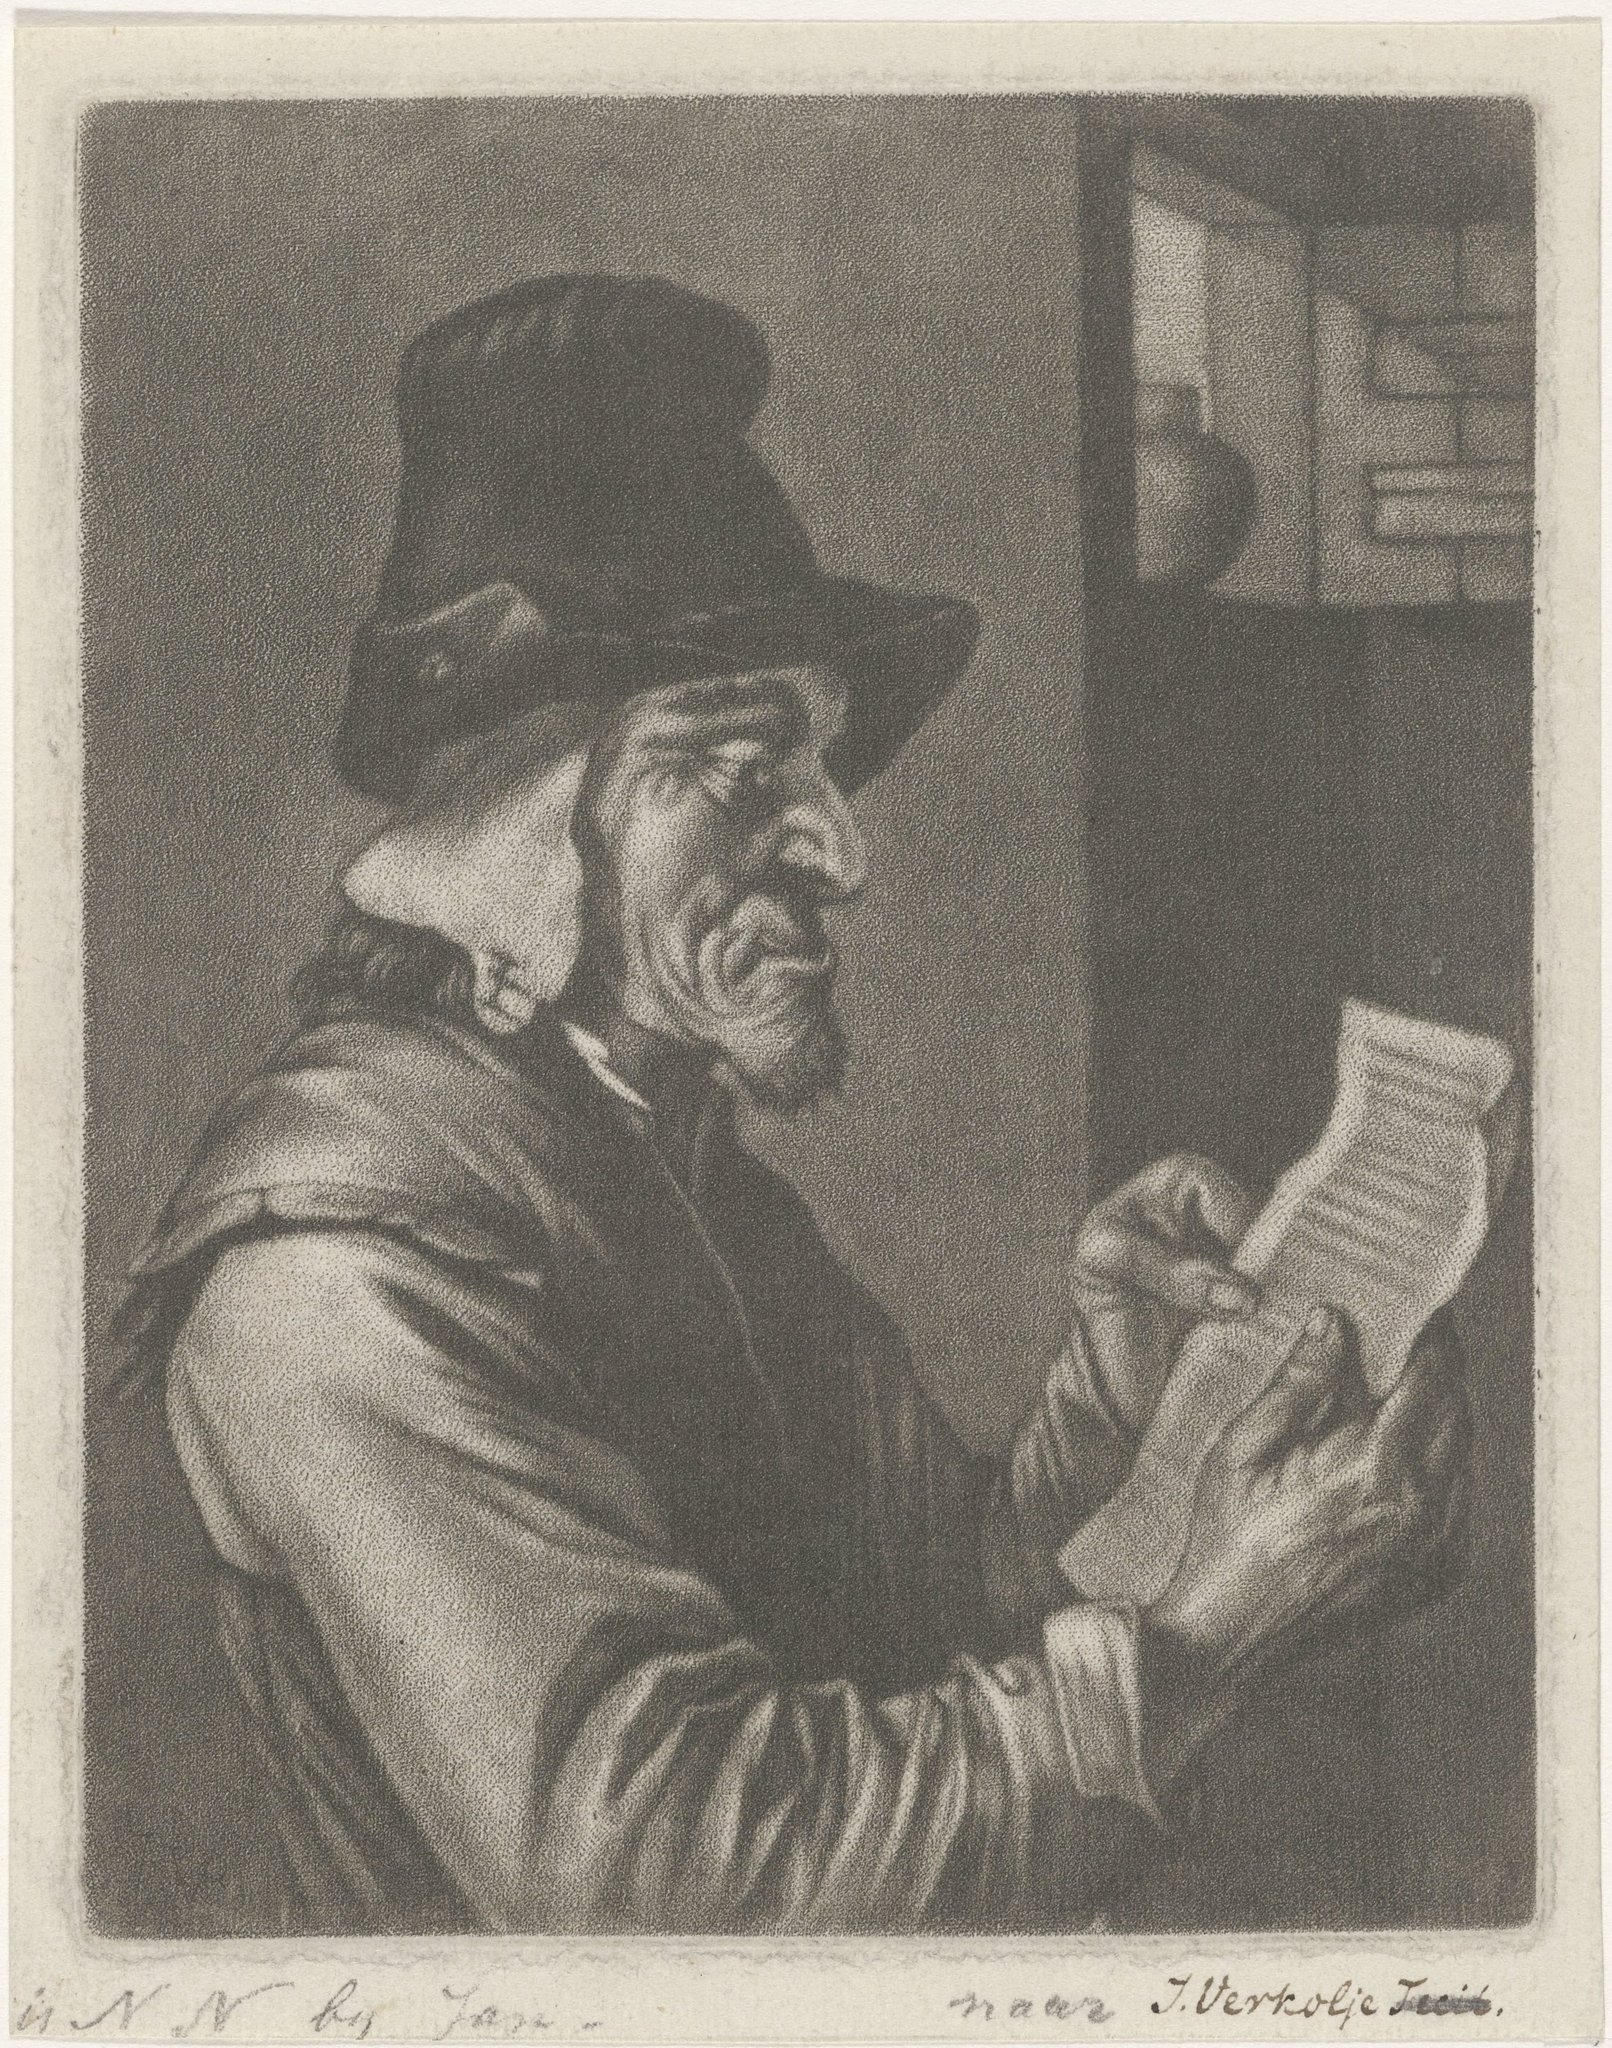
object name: print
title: Brieflezende man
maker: jan van der bruggen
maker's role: draughtsman, print maker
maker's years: 1649-1709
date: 1659-1740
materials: paper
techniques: engraving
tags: reading, letter, envelope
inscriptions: collector's mark: Lugt 2228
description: Een oude man leest een brief. Hij draagt een hoed. Rechts een geopend raampje, in het kozijn daarvan staat een bierkruik.